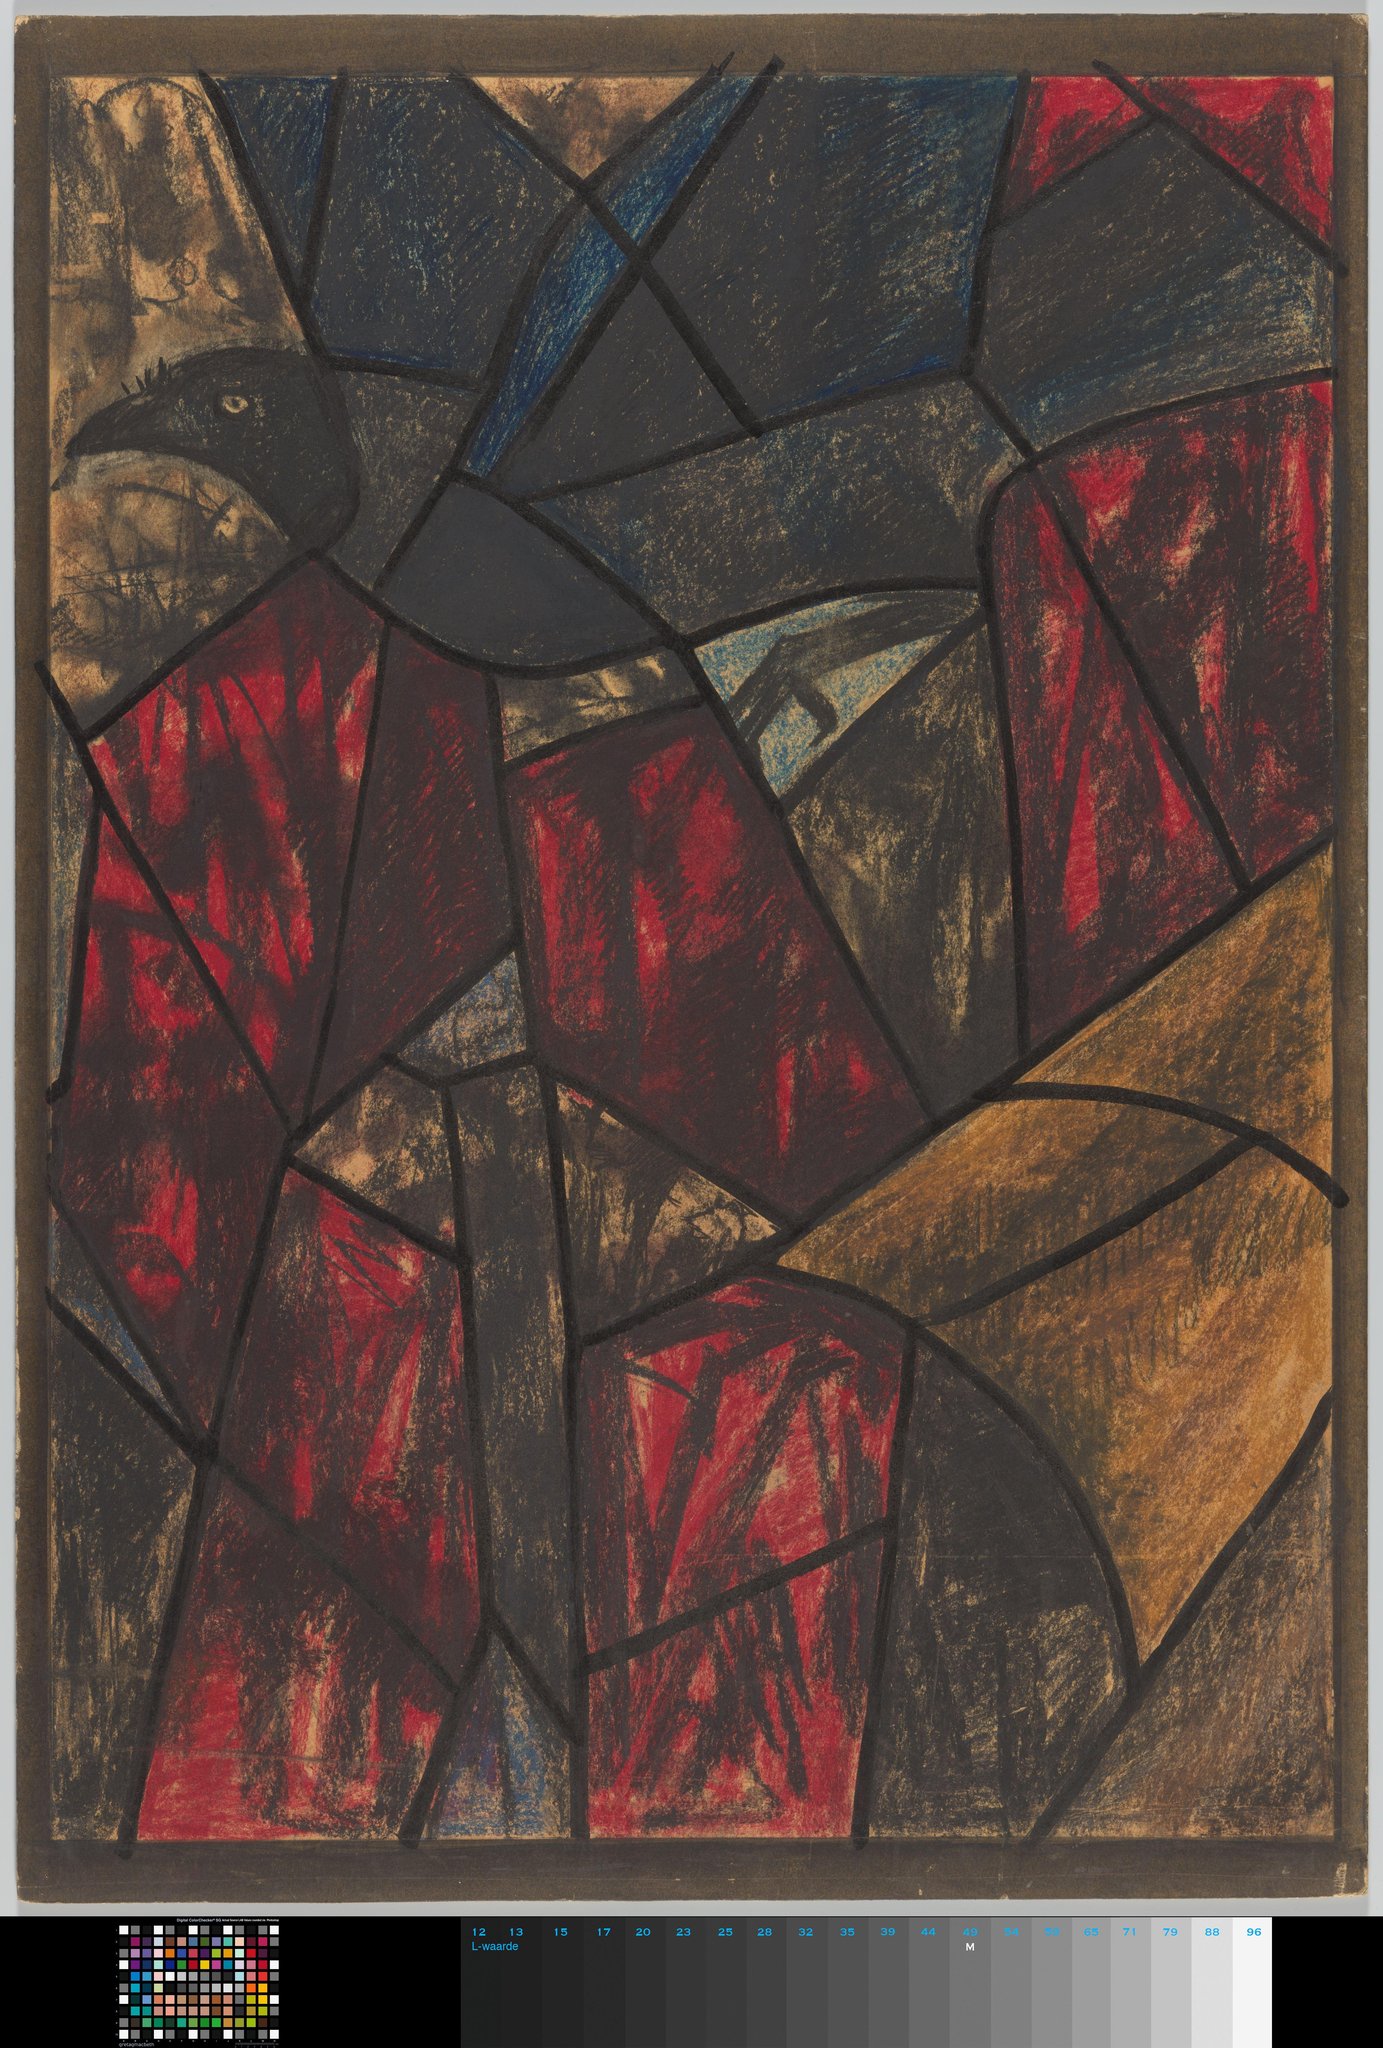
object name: design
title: Ontwerp voor raam in het Noordertransept in de Dom te Utrecht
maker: richard nicolaüs roland holst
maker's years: 1868-1938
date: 1934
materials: cardboard, chalk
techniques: brush